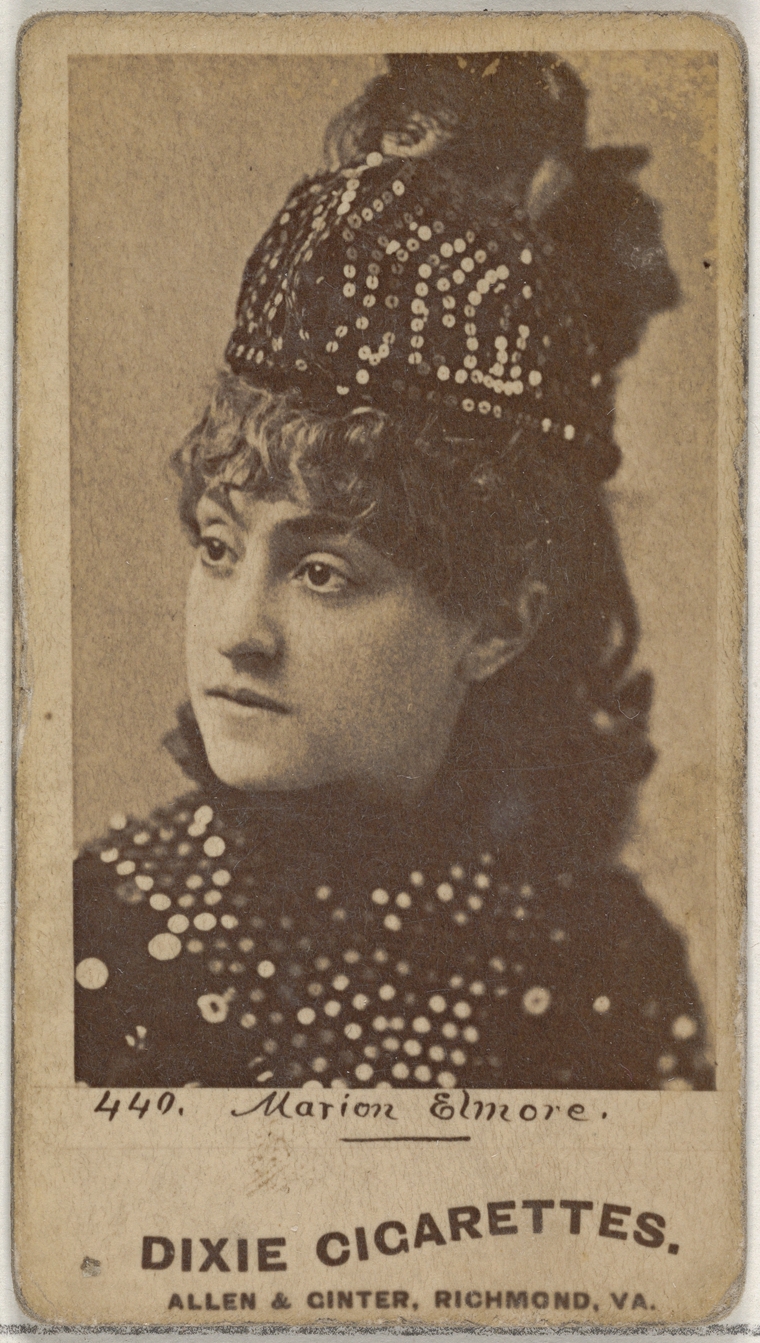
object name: photograph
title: Card 440, Marion Elmore, from the Actors and Actresses series (N45, Type 7) for Dixie Cigarettes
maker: allen & ginter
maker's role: publisher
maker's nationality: american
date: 1888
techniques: albumen silver print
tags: portraits,women,actresses